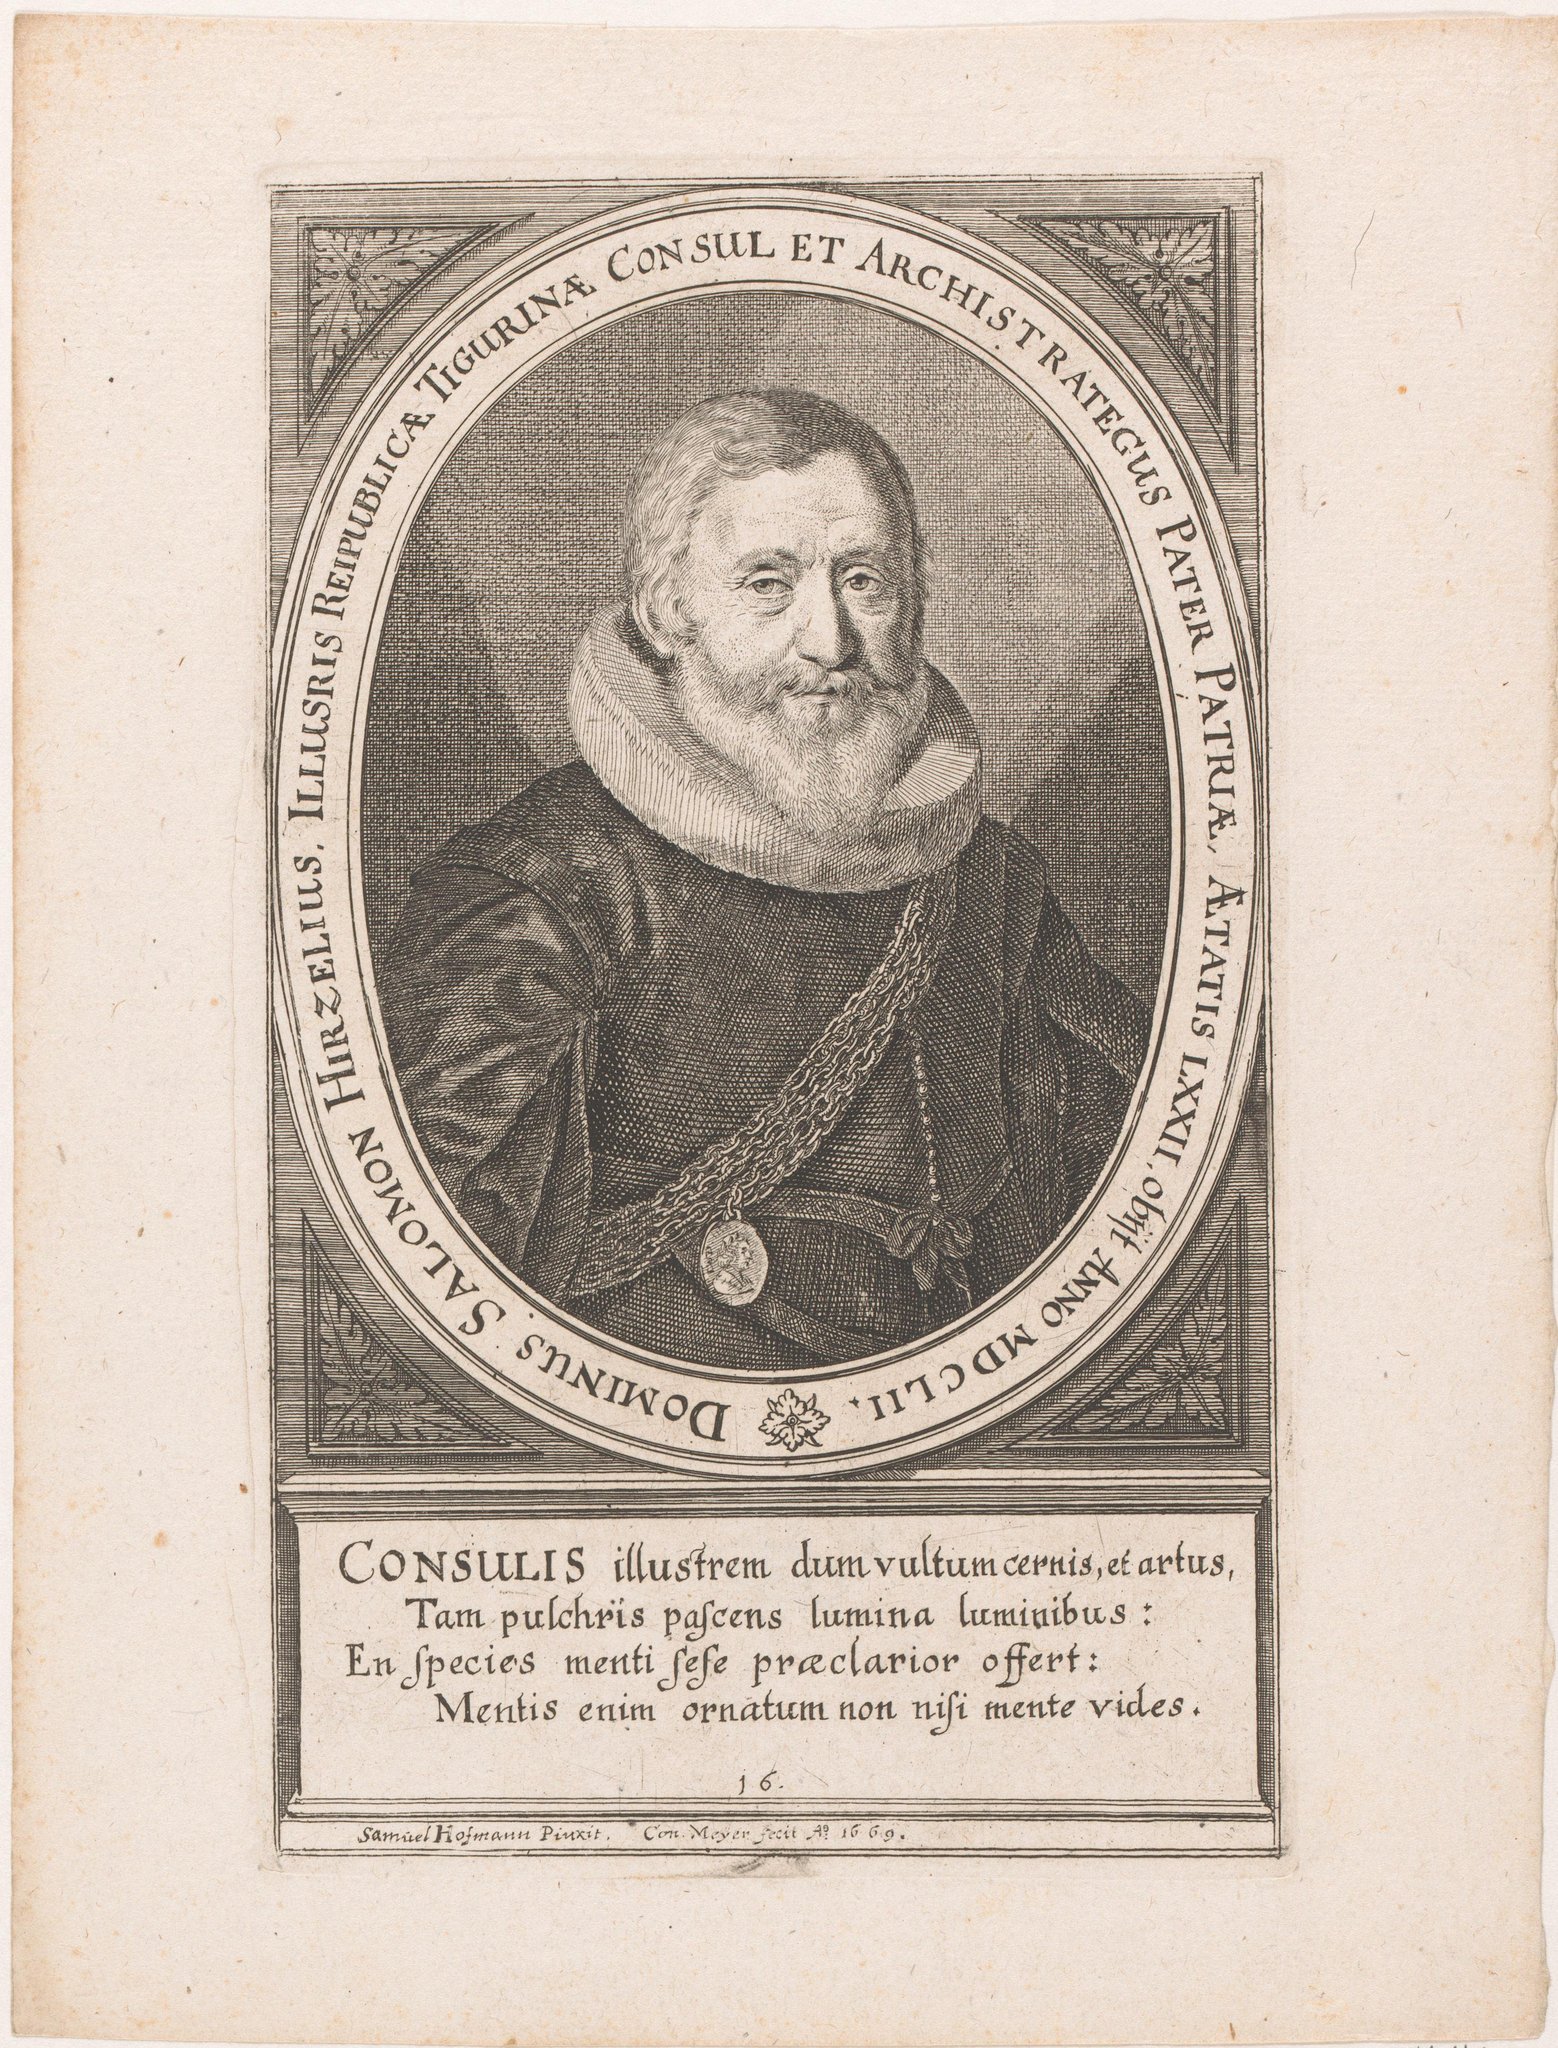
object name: print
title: Portretten van burgemeesters van Zürich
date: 1669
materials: paper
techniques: engraving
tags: mayor, mayor, burgomaster, other non-personal regalia, e.g. mayor chain, historical persons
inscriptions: collector's mark: Lugt 2228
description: Onderdeel van een serie van 67(?) portretten van burgemeesters van Zürich. Zie Hollstein German 110, 1-26.